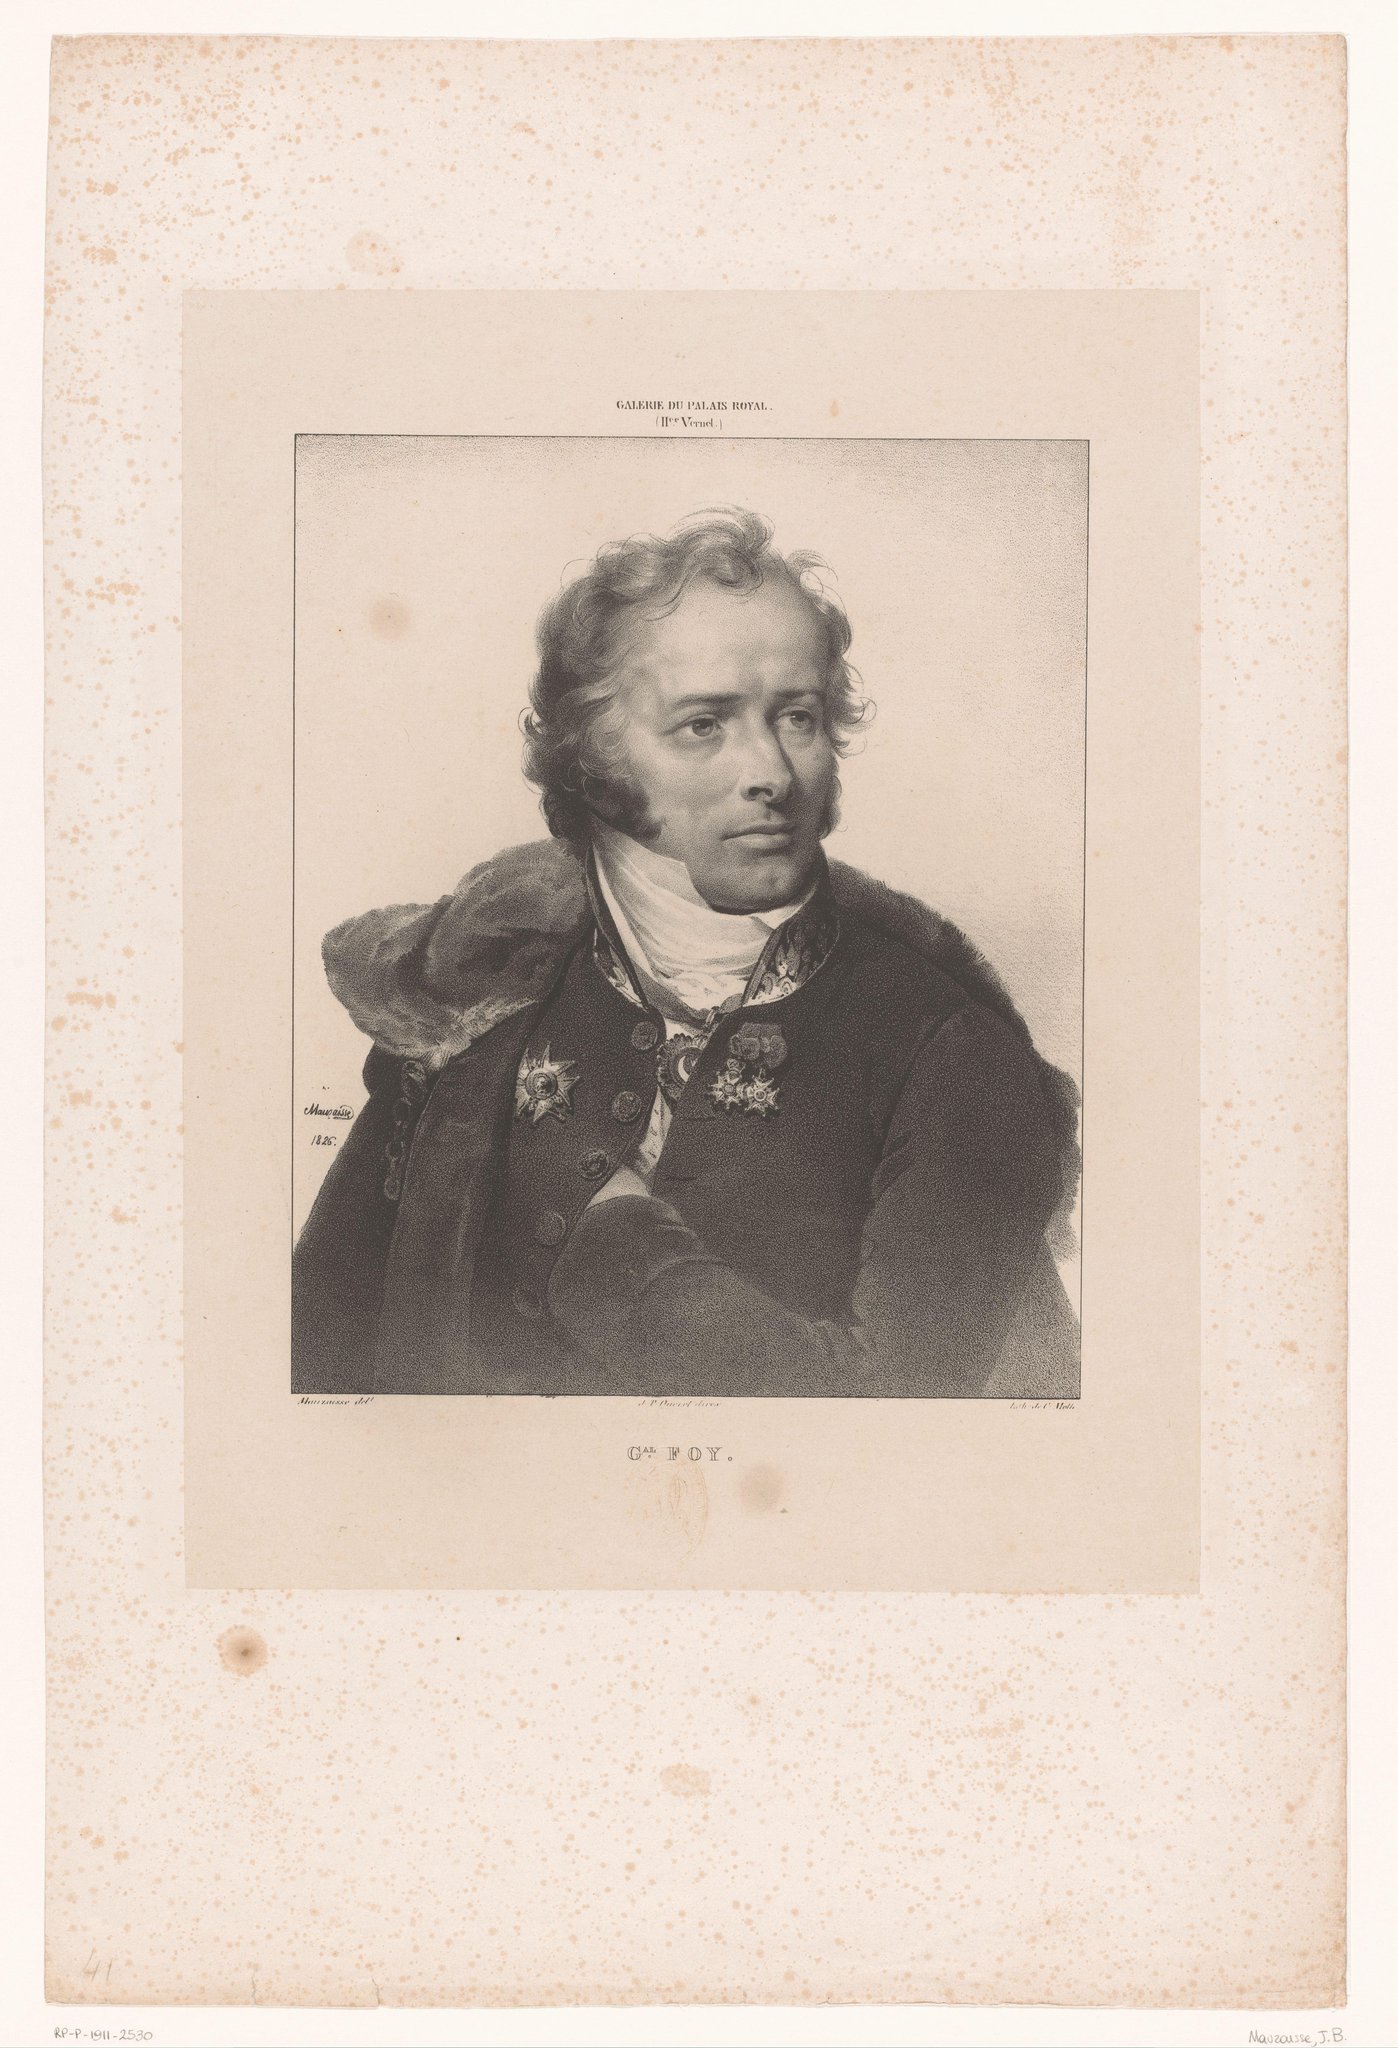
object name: print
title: Gal. Foy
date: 1826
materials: paper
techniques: lithograph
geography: paris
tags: paris, politician, maximilien sébastien foy, commander-in-chief, general, marshal, historical persons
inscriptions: collector's mark: Lugt 2228, check stamp: Lugt 1999d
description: Onderdeel van een prentserie over de schilderijenverzameling van Lodewijk Filips, hertog van Orléans - de latere koning Lodewijk Filips I.